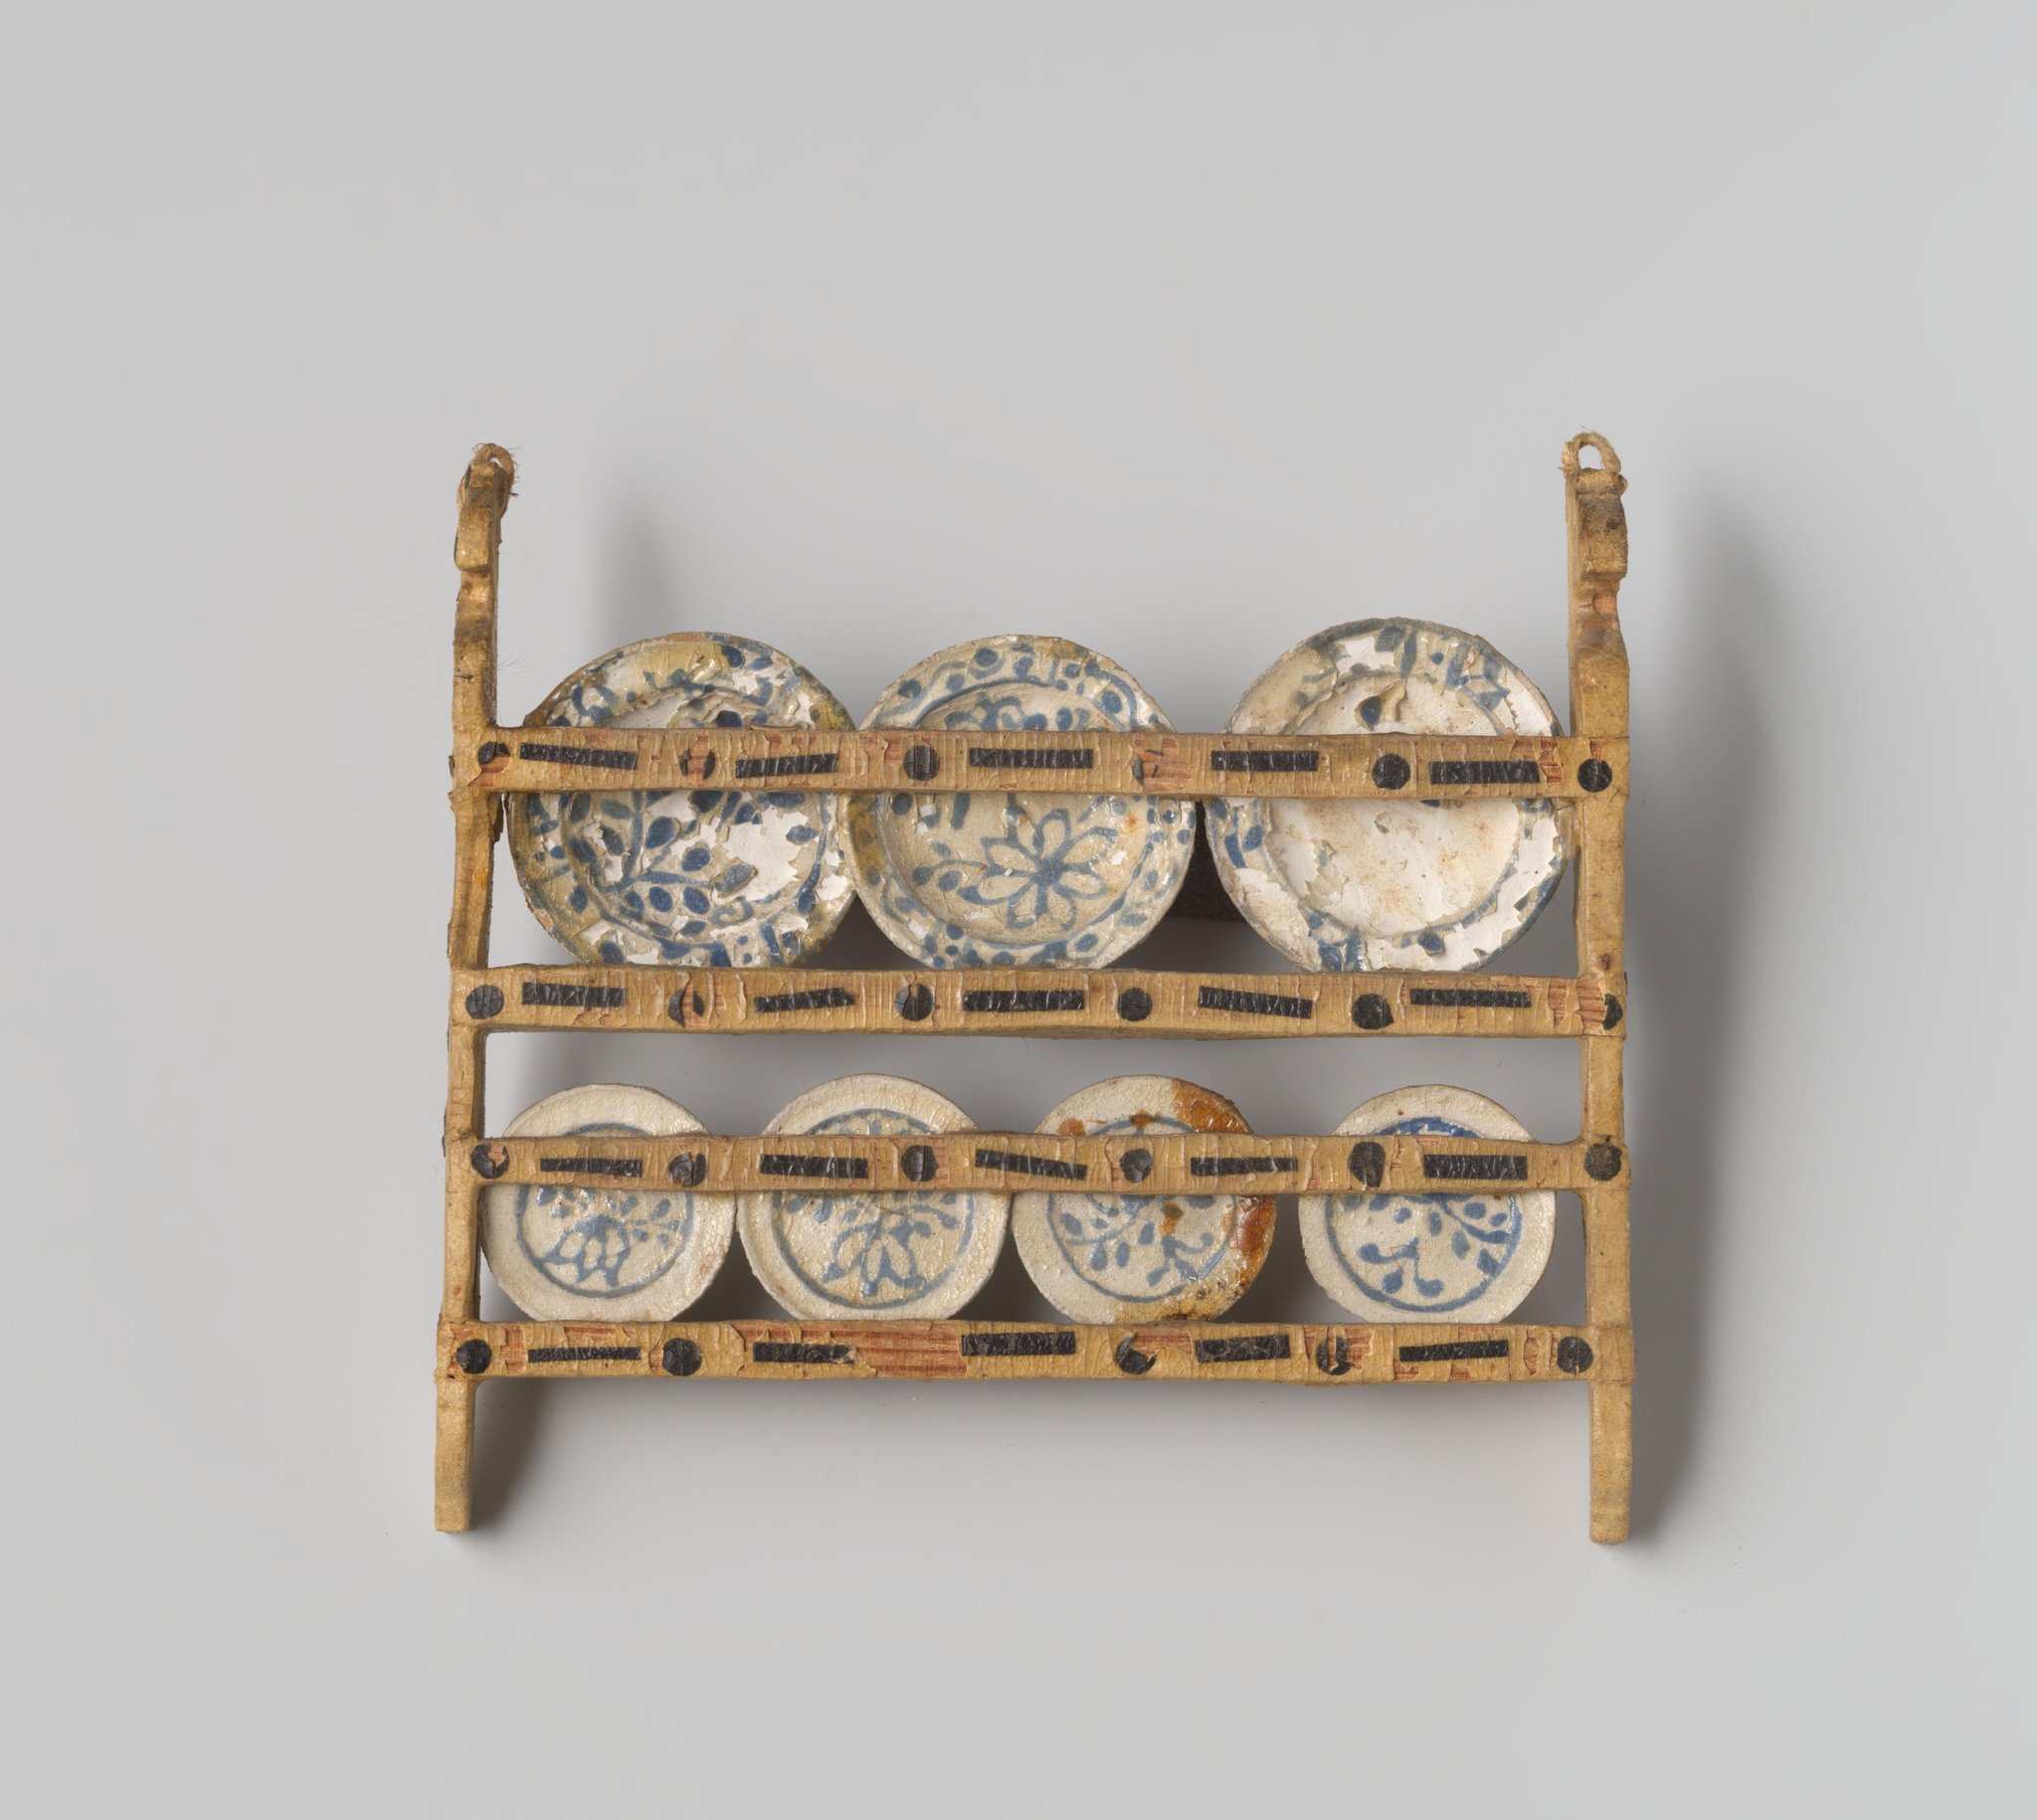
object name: miniature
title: Bordenrek, vervaardigd van bordpapier en hout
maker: Anonymous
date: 1676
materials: board, wood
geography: amsterdam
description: Bordenrek, vervaardigd van bordpapier en hout, crèmekleurig gelakt en versierd met zwarte stippen en balken. Bovenaan de zijwanden zijn ophangogen aangebracht, waardoorheen touwen.